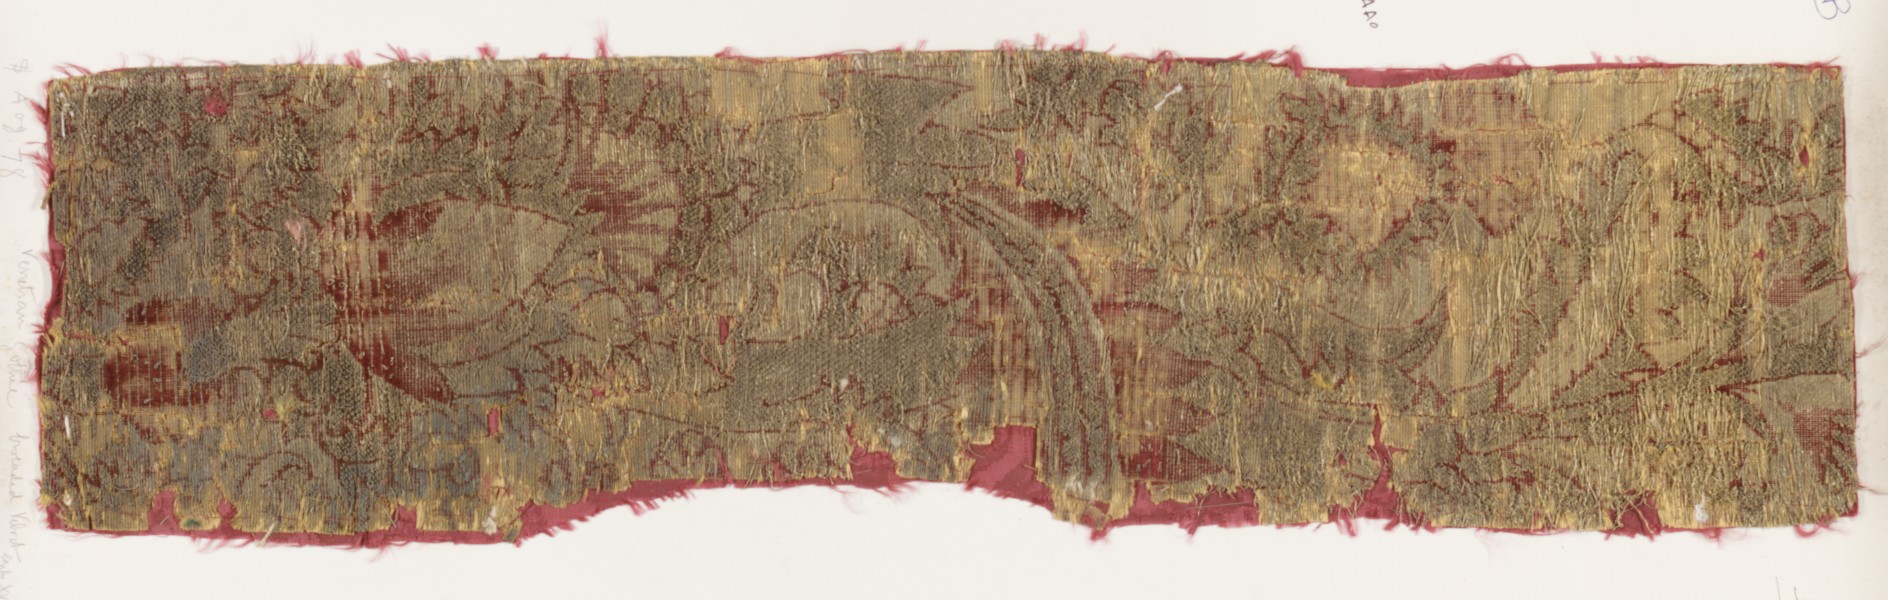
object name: fragment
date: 1501-1533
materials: metal thread, silk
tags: flowers